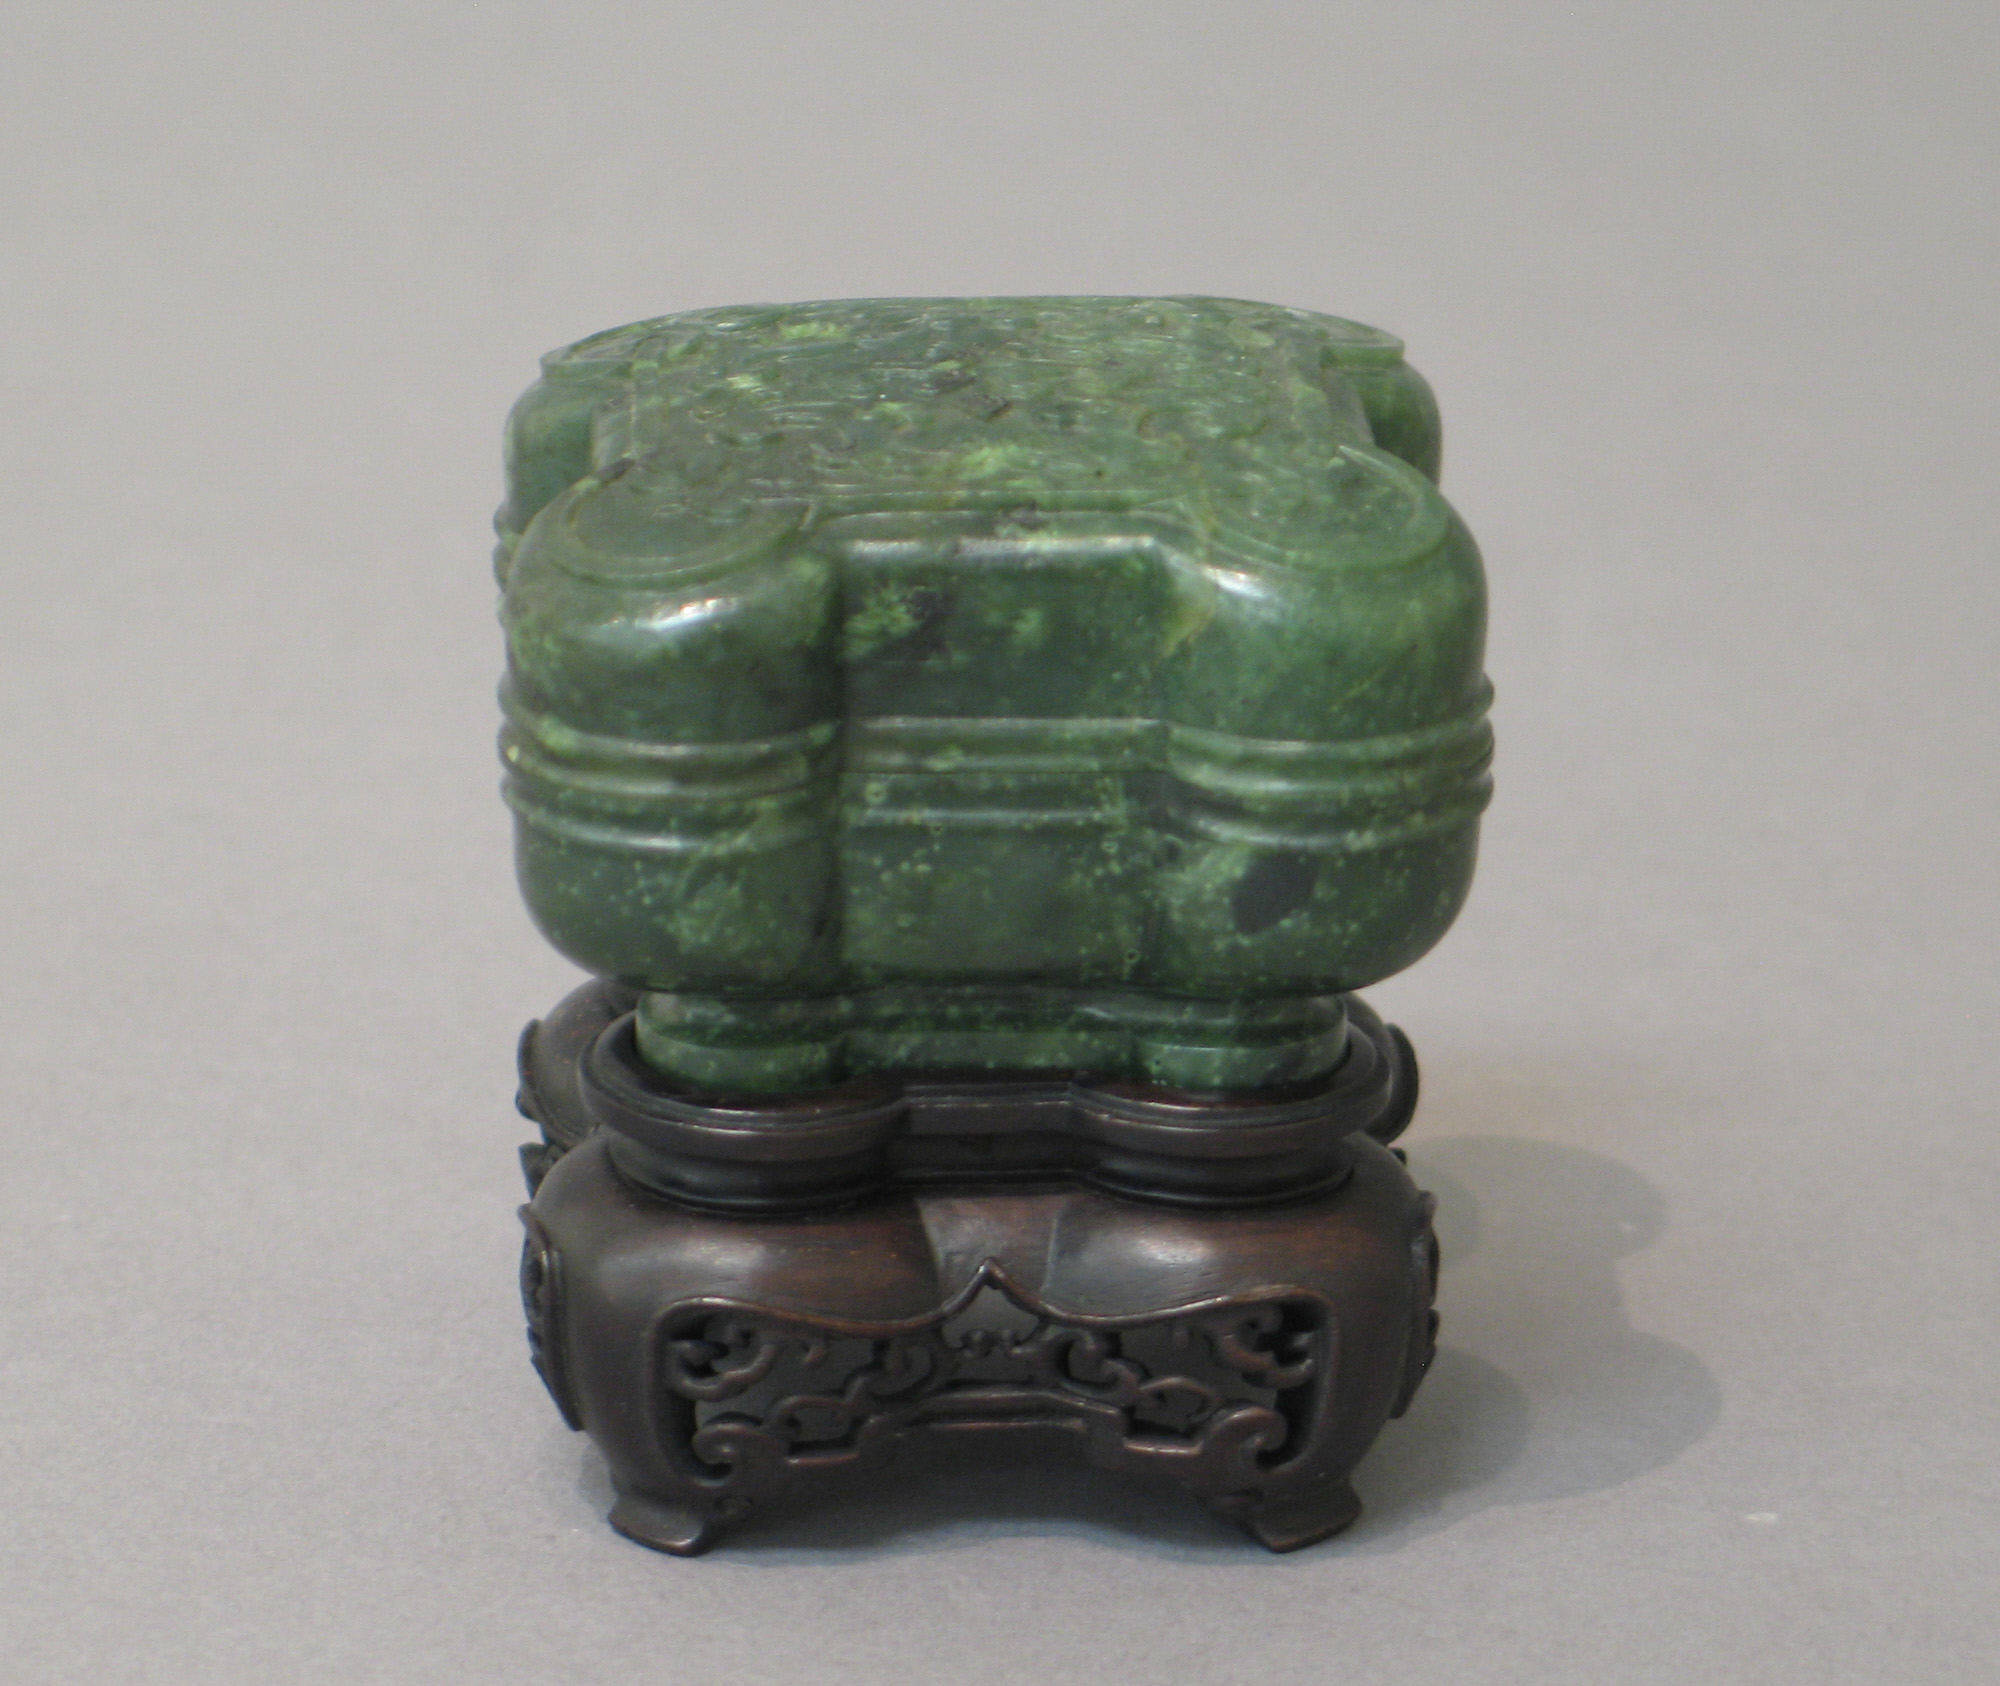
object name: box with cover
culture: chinese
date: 1736-1795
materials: jade